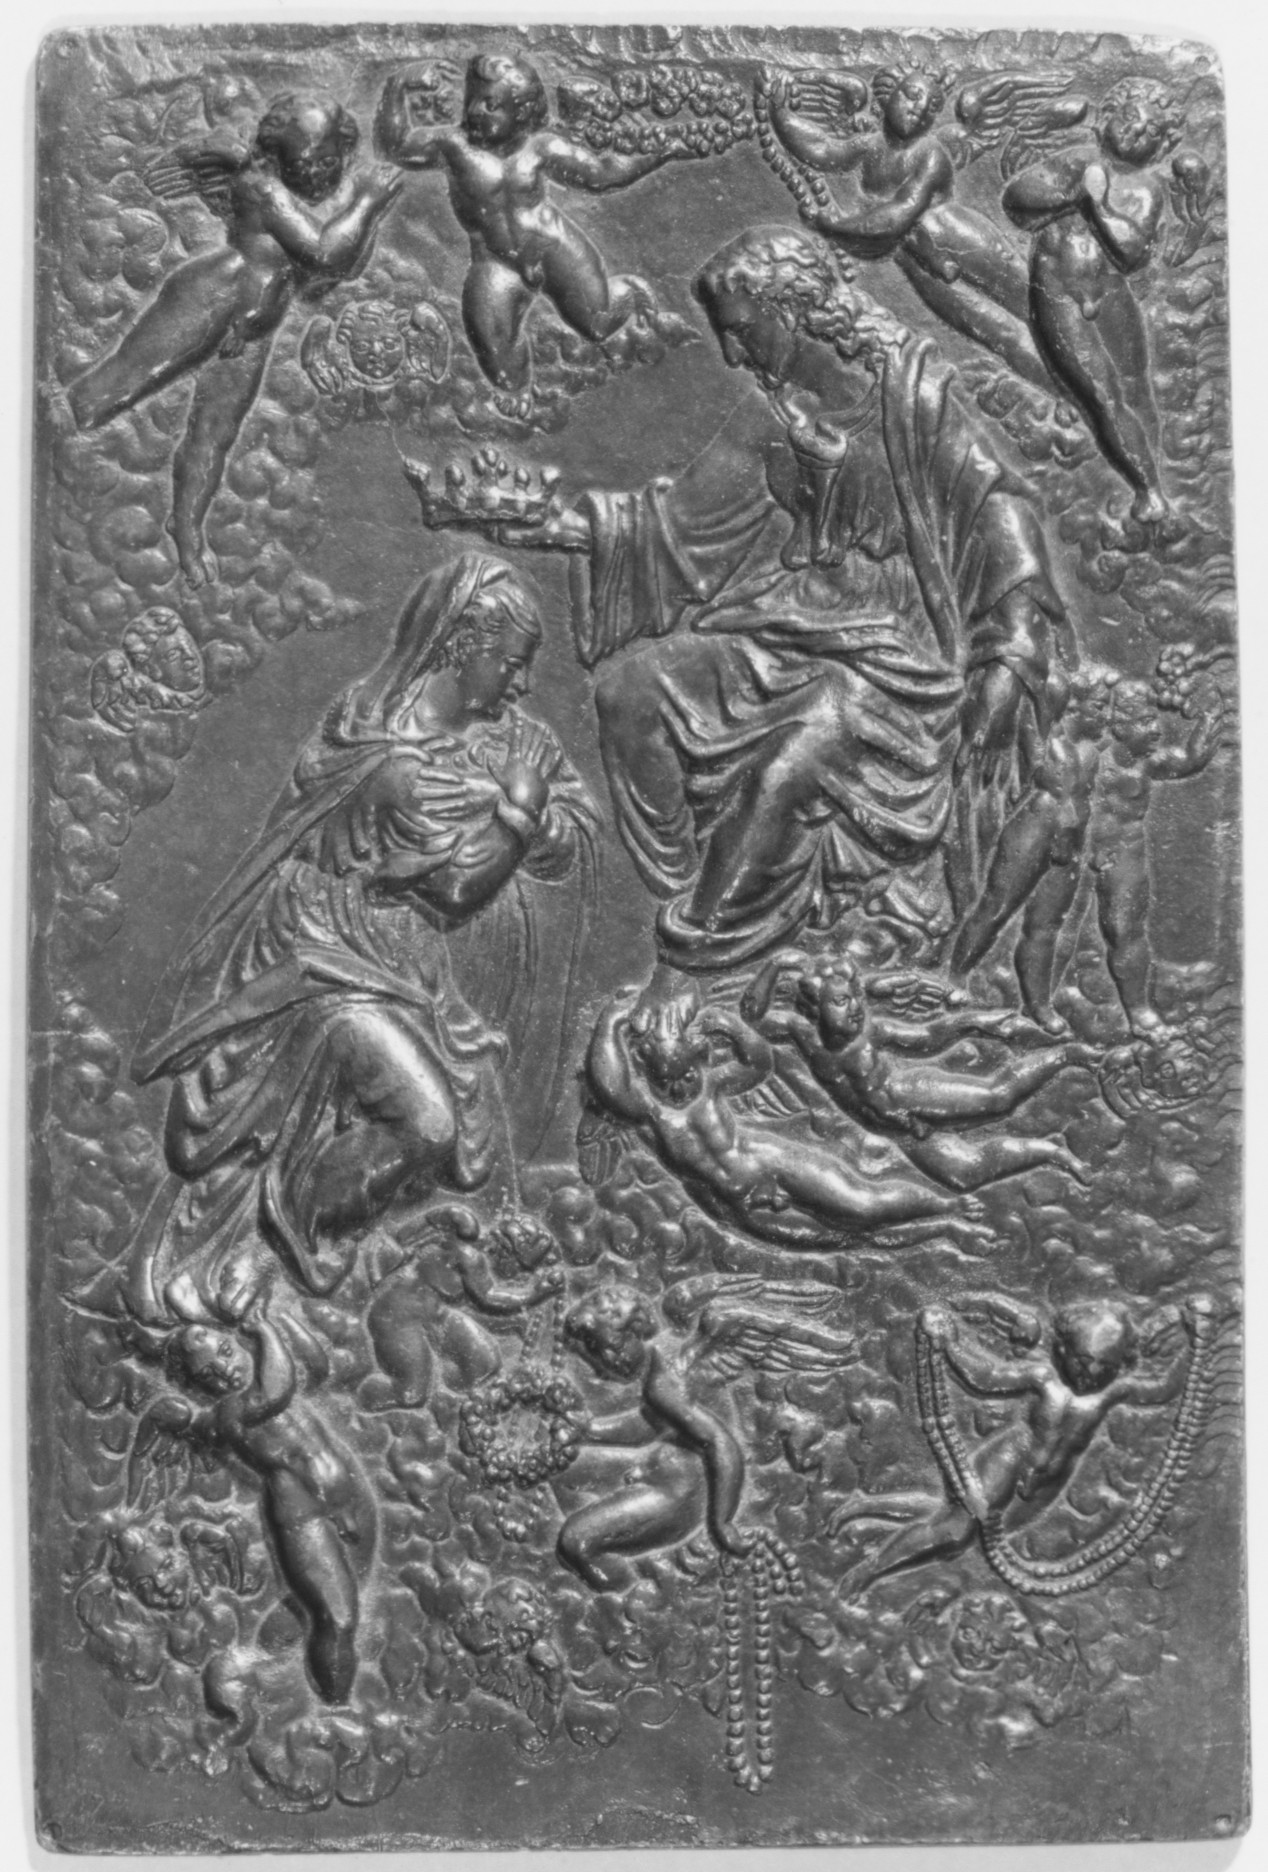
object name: plaquette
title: Coronation of the Virgin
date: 1575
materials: lead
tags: angels,virgin mary,jesus